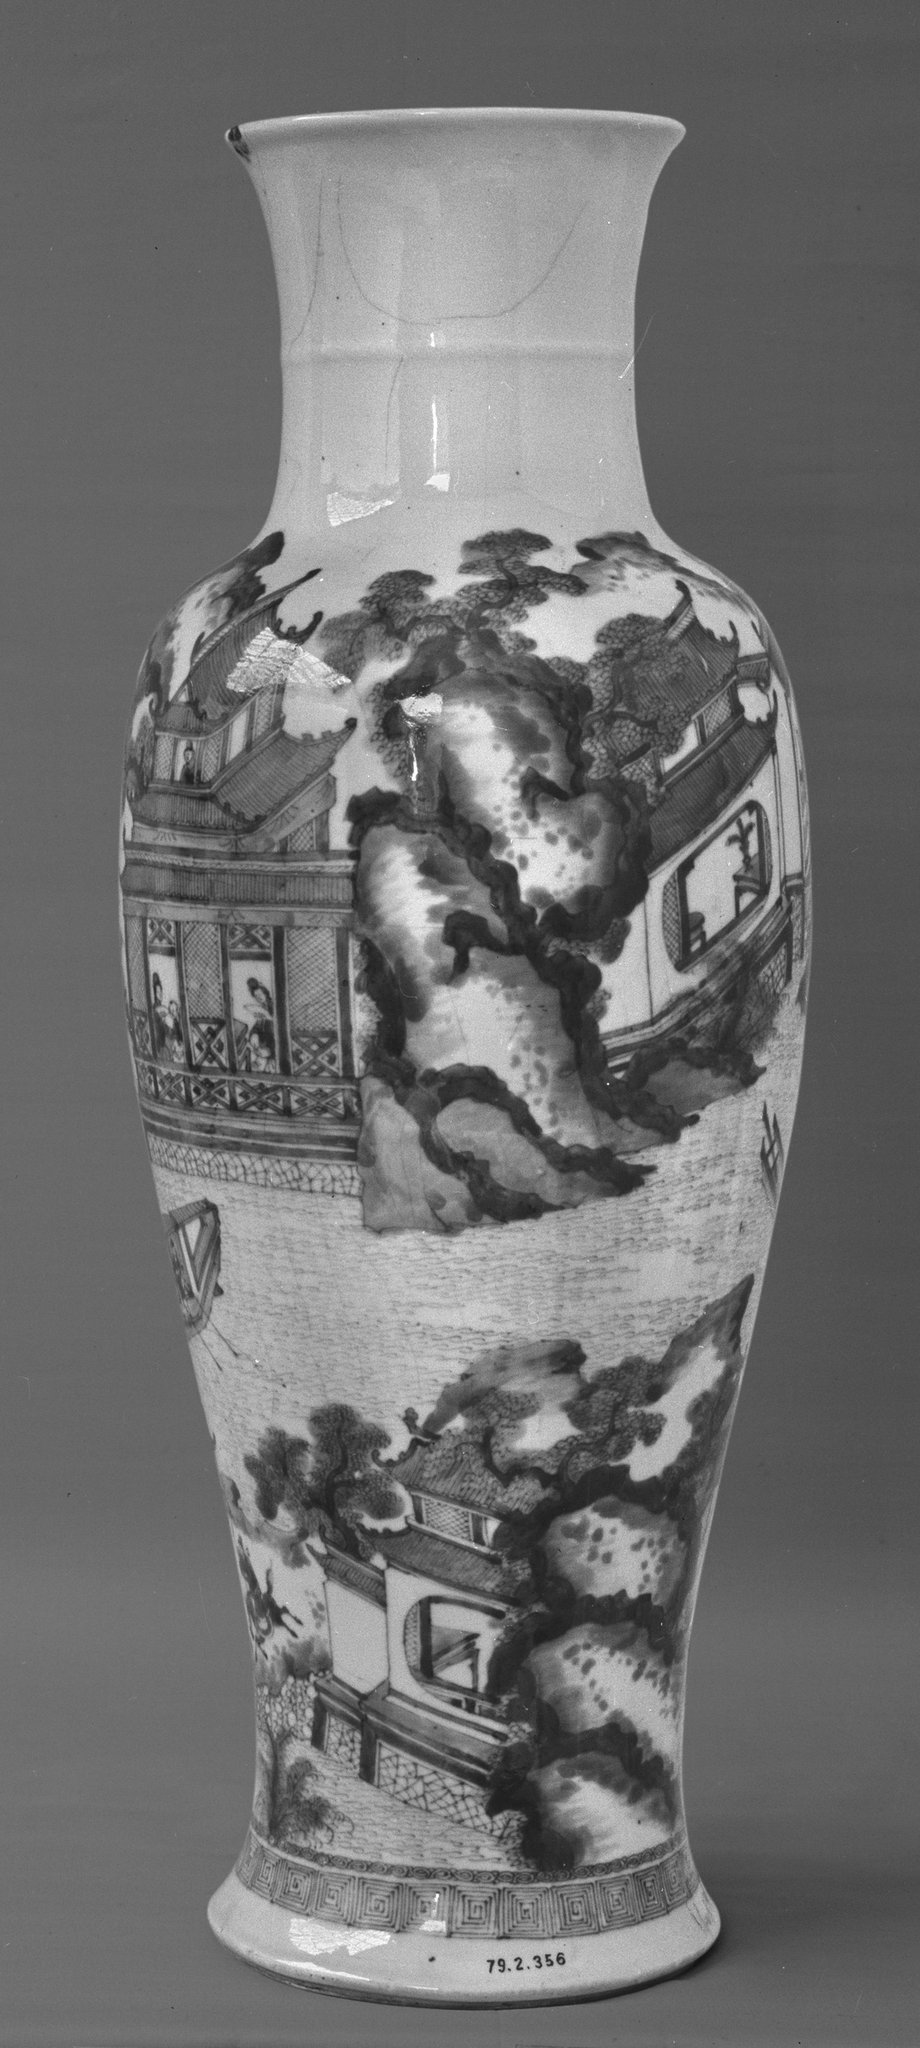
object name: vase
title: Vase with Garden Scene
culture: chinese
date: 1667-1733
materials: cobalt, metal, porcelain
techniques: painting, underglaze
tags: houses,gardens